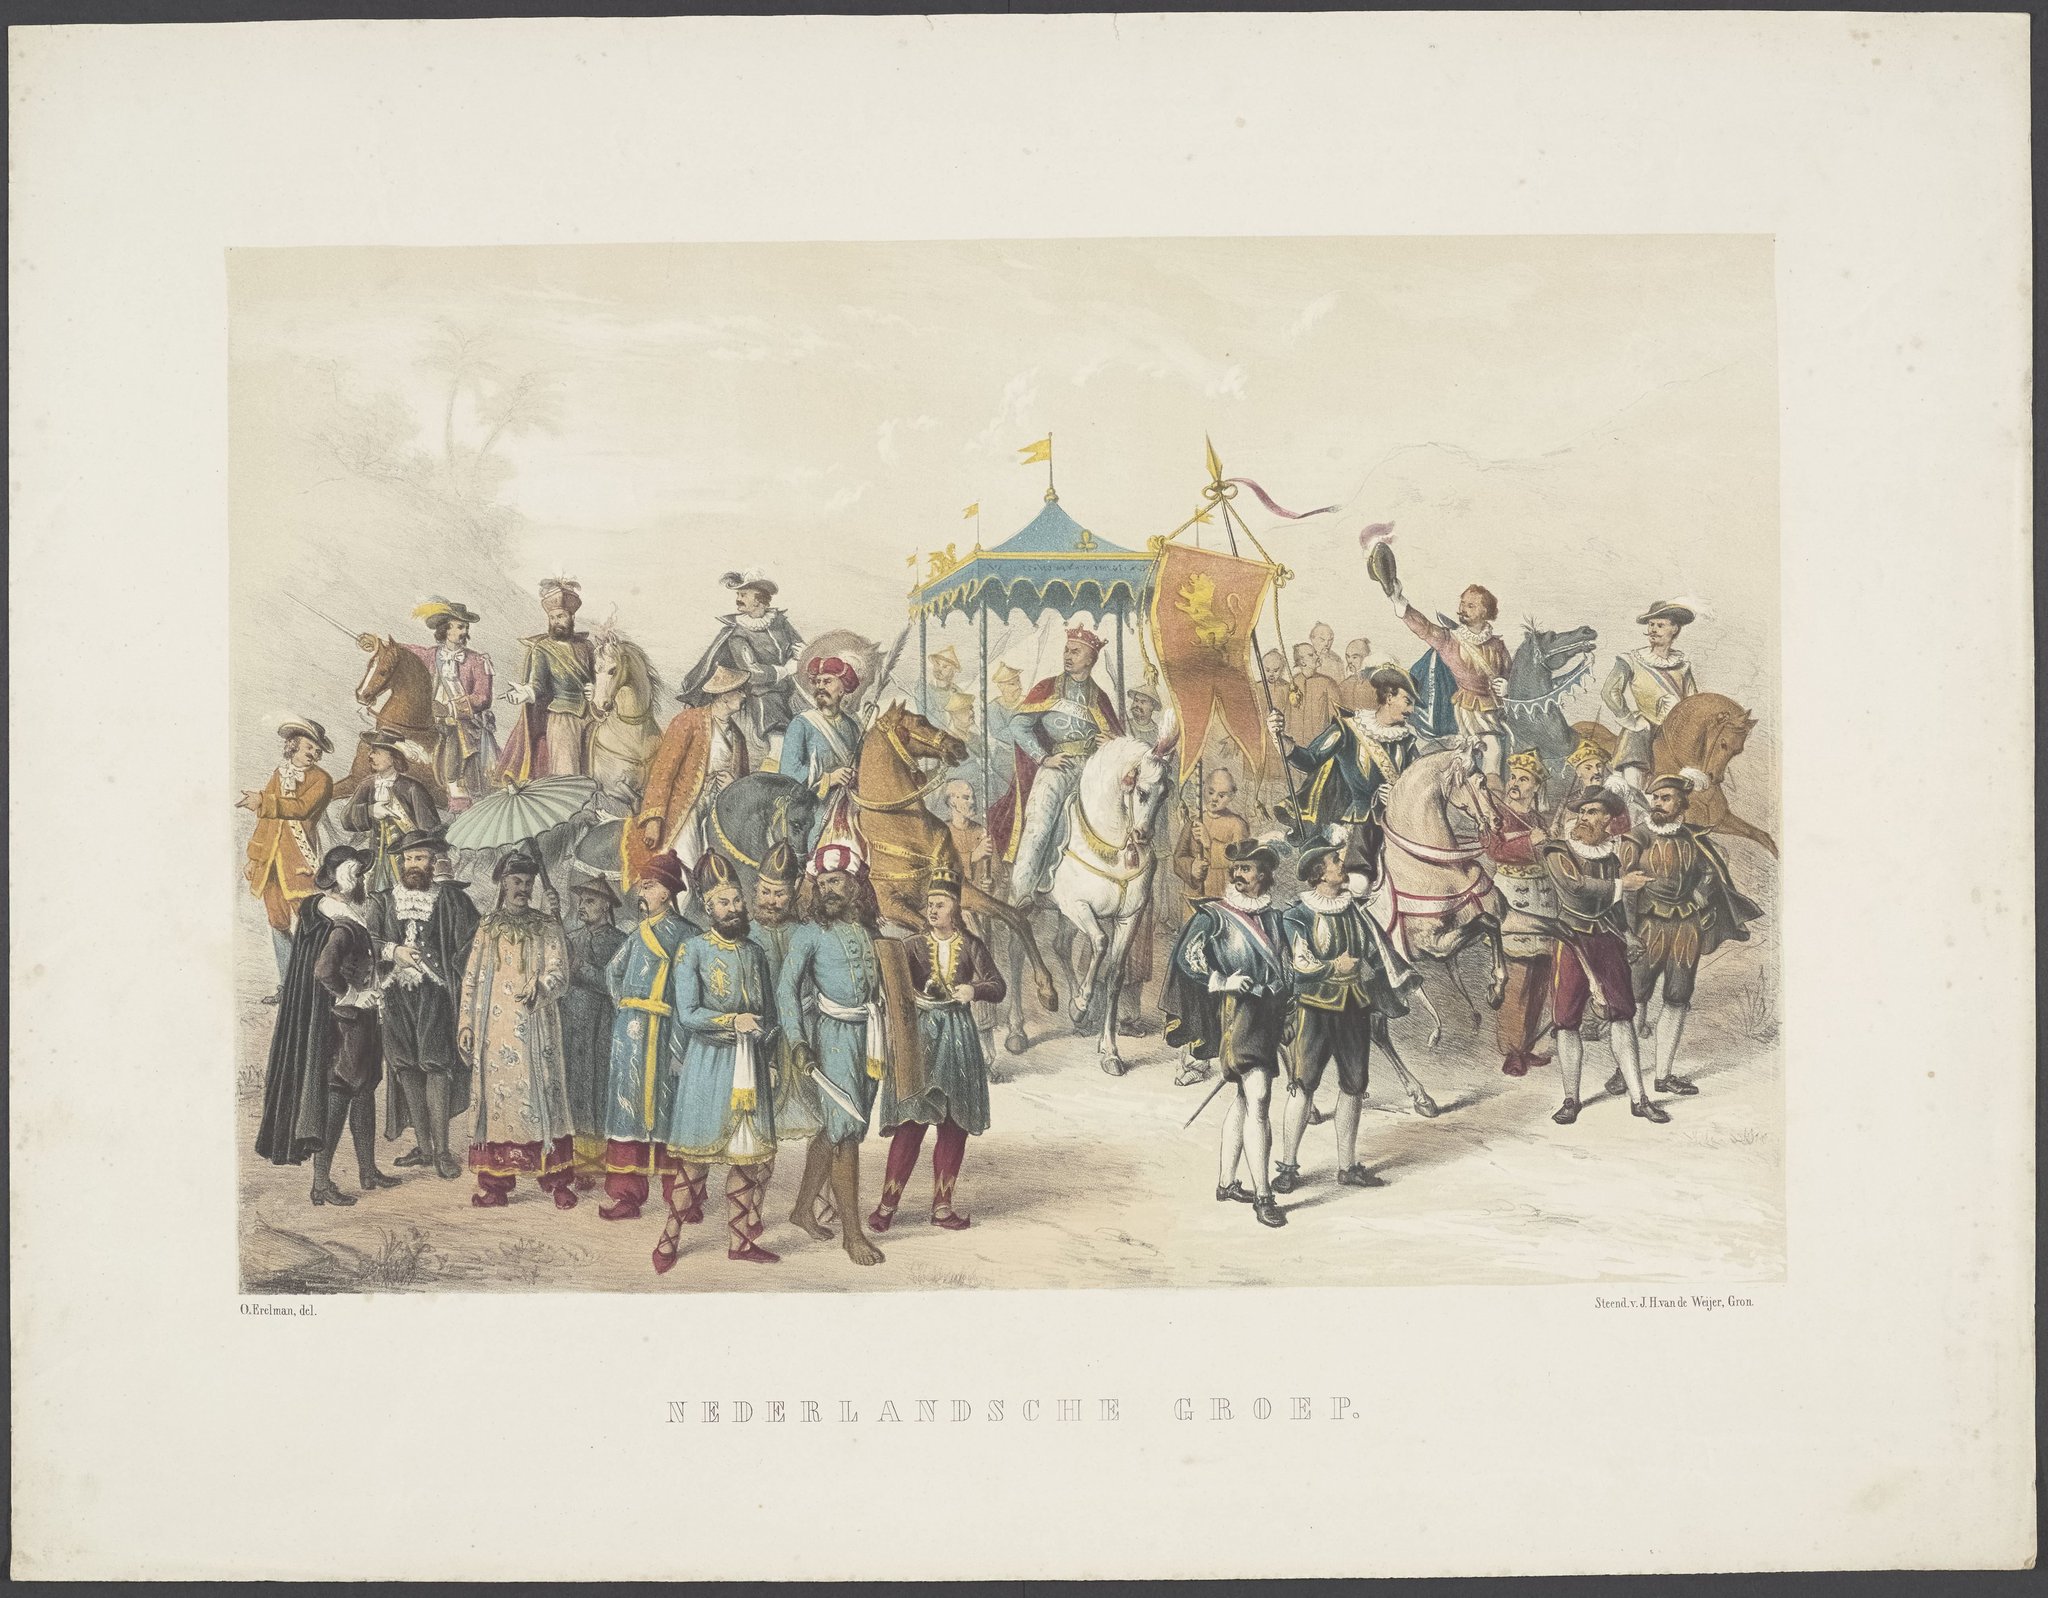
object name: print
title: Nederlandsche groep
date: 1859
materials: paper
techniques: hand coloring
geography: groningen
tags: students' pageant, costumes used in pageants, dutch east indies, the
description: De Nederlandse groep met een Indonesische vorst te paard. Onderdeel van de serie van drie platen plus verklaring van de historische optocht in maskerade met als onderwerp de vestiging van Europeanen in de Indonesische archipel, opgevoerd door de studenten van de Hogeschool van Groningen op 13 oktober 1859.